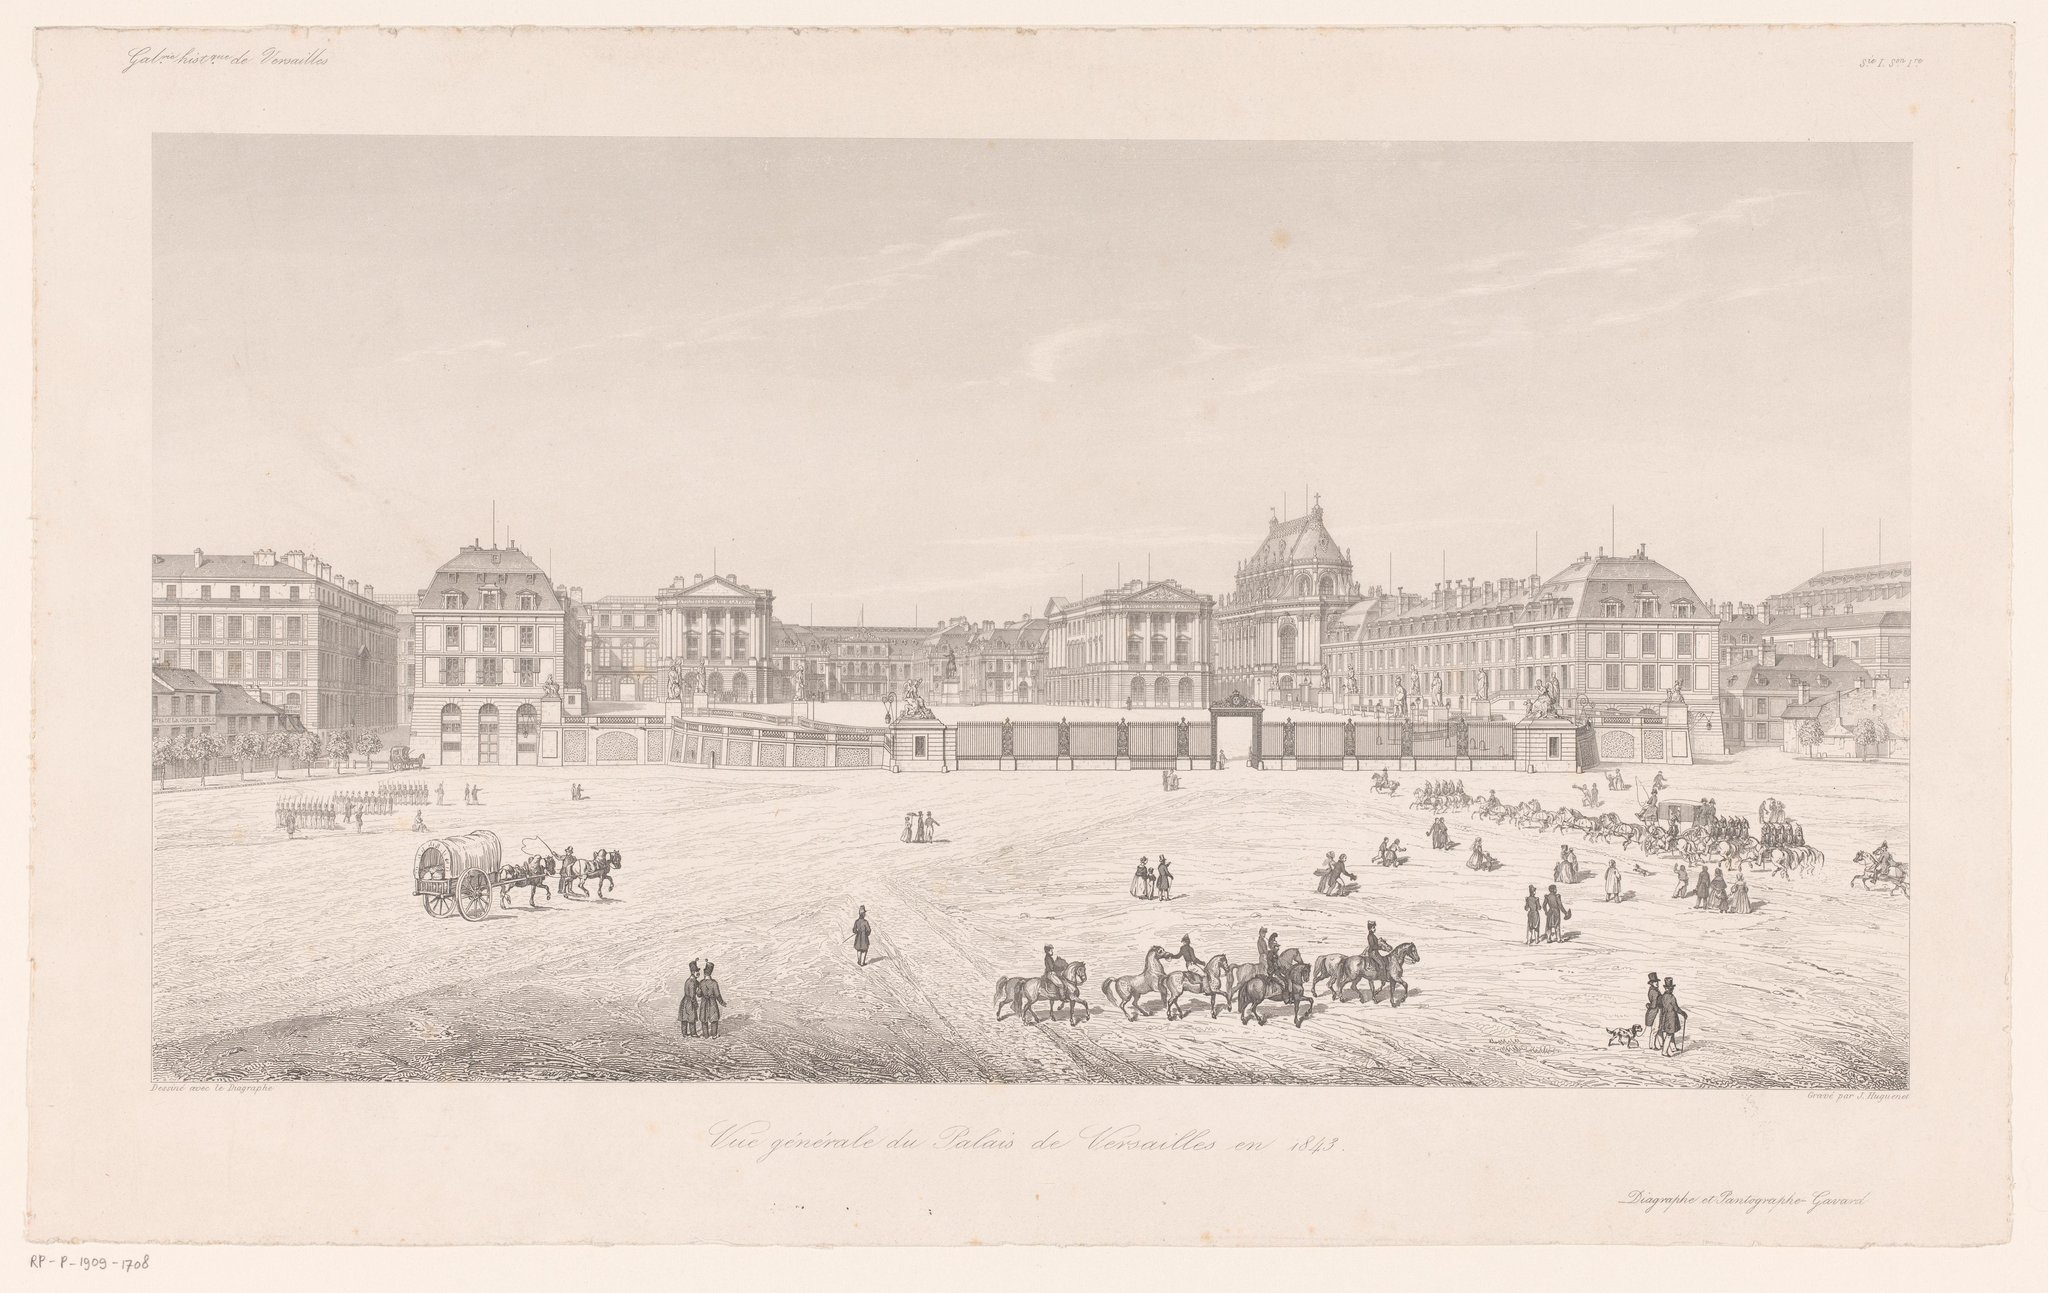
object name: book illustration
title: Vue générale du Palais de Versailles en 1843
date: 1843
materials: paper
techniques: etching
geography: paris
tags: city-view in general; 'veduta', palace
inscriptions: collector's mark: Lugt 2228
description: Mogelijk prent uit een (latere) editie van Galeries historiques de Versailles. Parijs: Charles Gavard, 1838-1841.